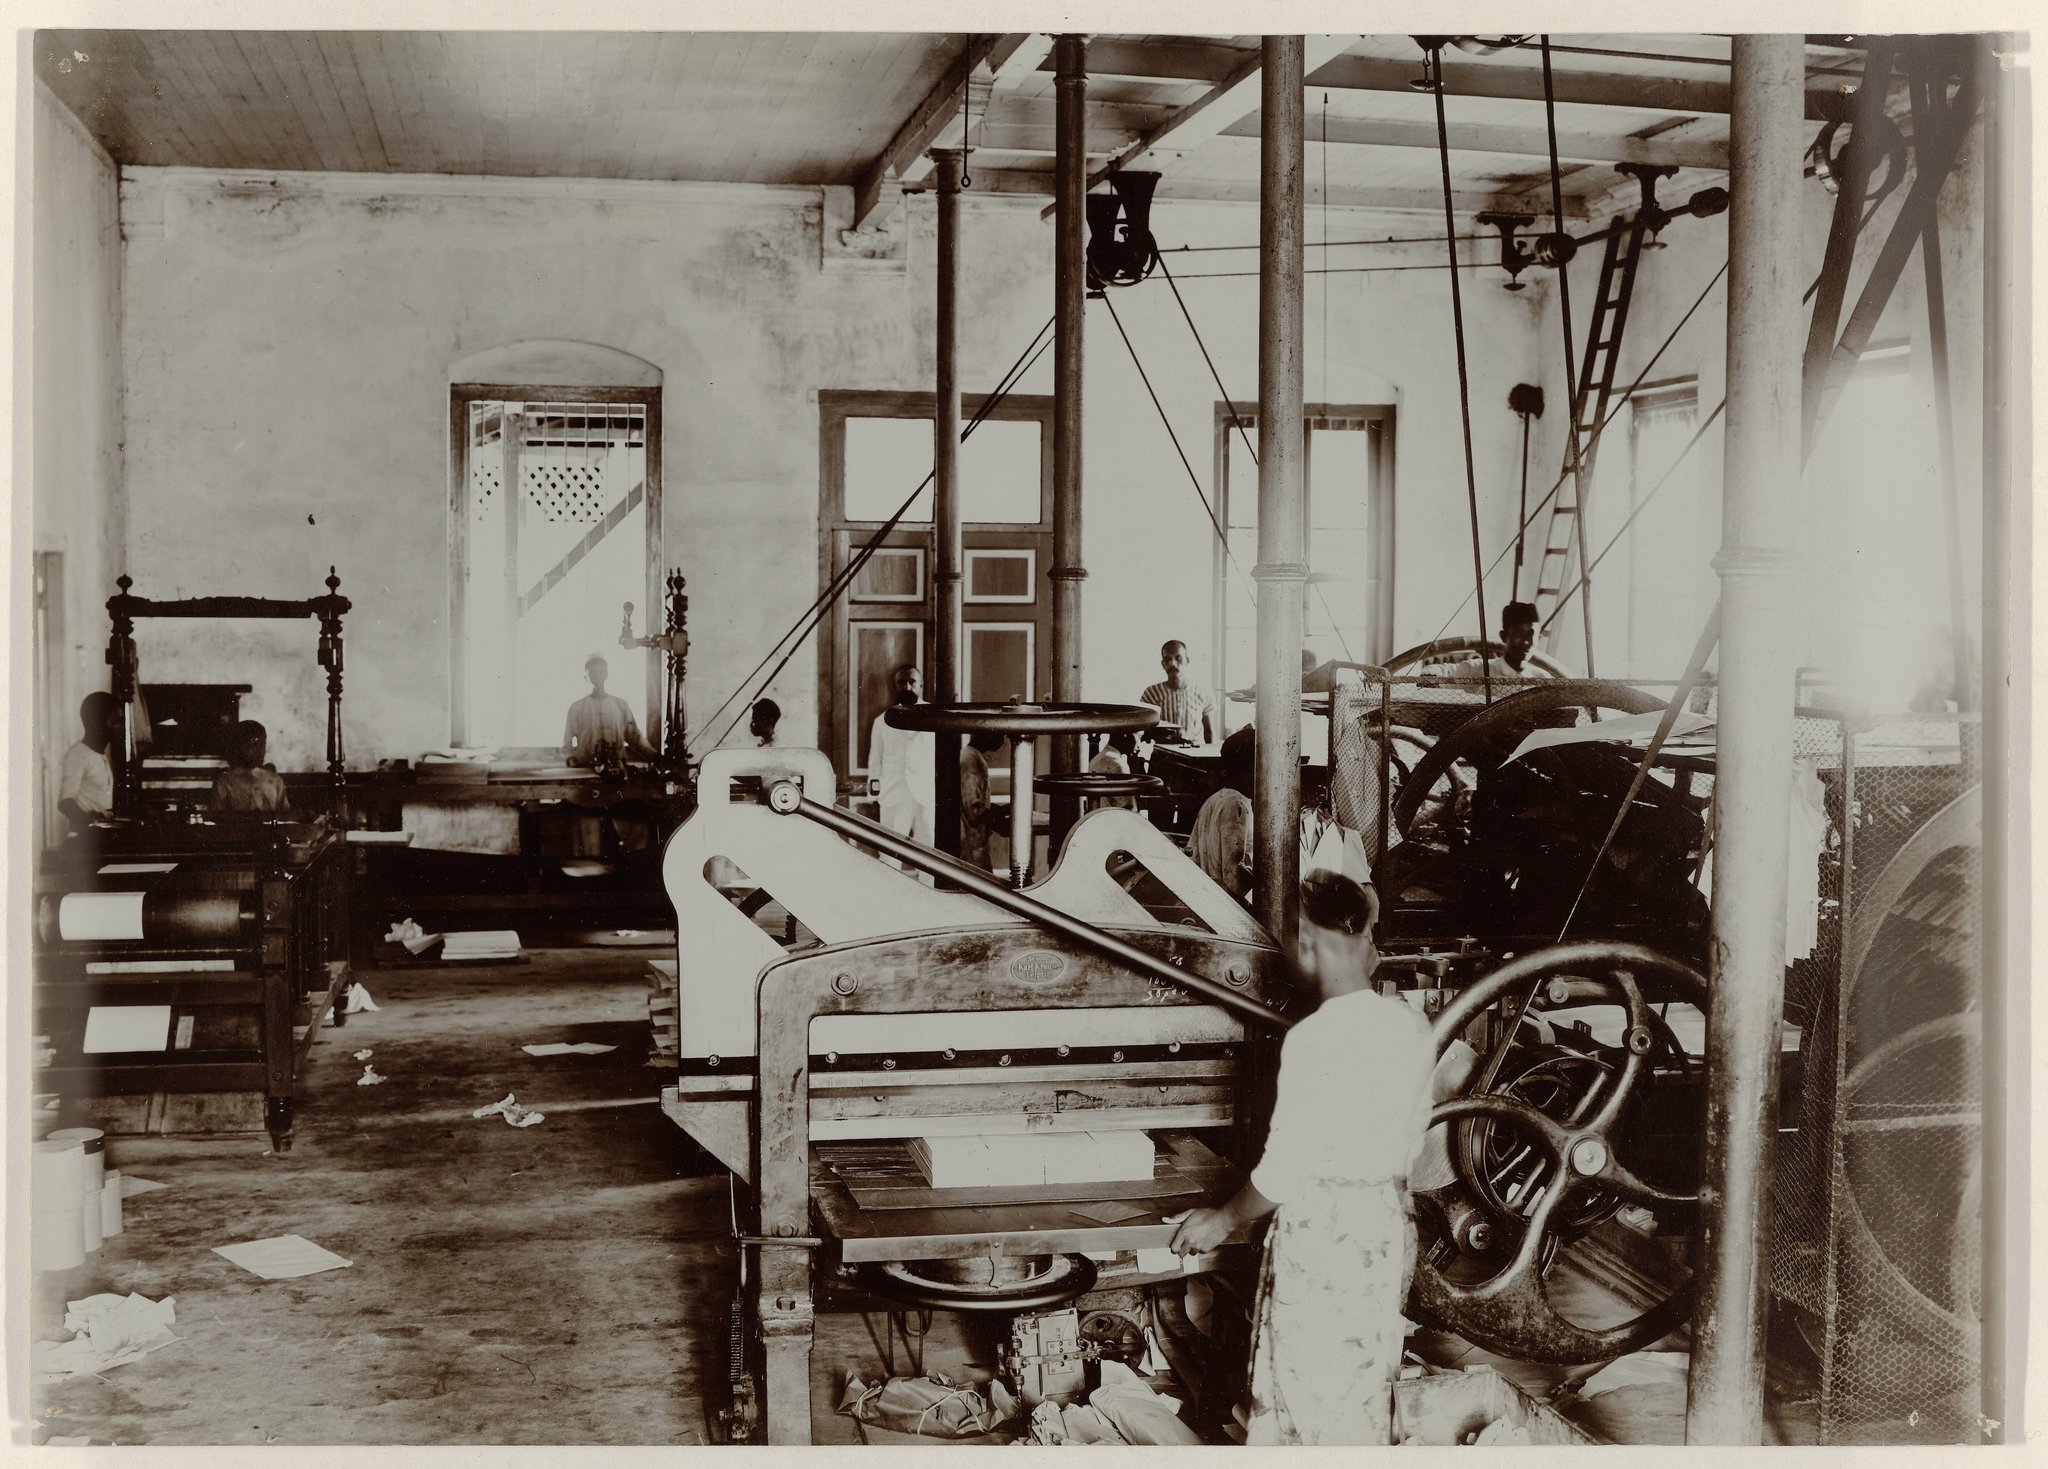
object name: photograph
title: Drukkerij van de Deli Courant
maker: Anonymous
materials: photographic support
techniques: collodion silver print, gelatin silver print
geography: medan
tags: dutch east indies, the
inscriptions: inscription: ‘helft drukkerij’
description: Gezicht in de drukkerij van de Deli Courant te Medan, met Javaanse werknemers aan de machines. Onderdeel van een aparte groep van negen foto's uit 1908 binnen de gehele groep van 49 losse zwart-wit foto's van verschillend formaat over de uitgeverij en drukkerij van de krant Deli Courant in Medan in de periode 1885-1947.